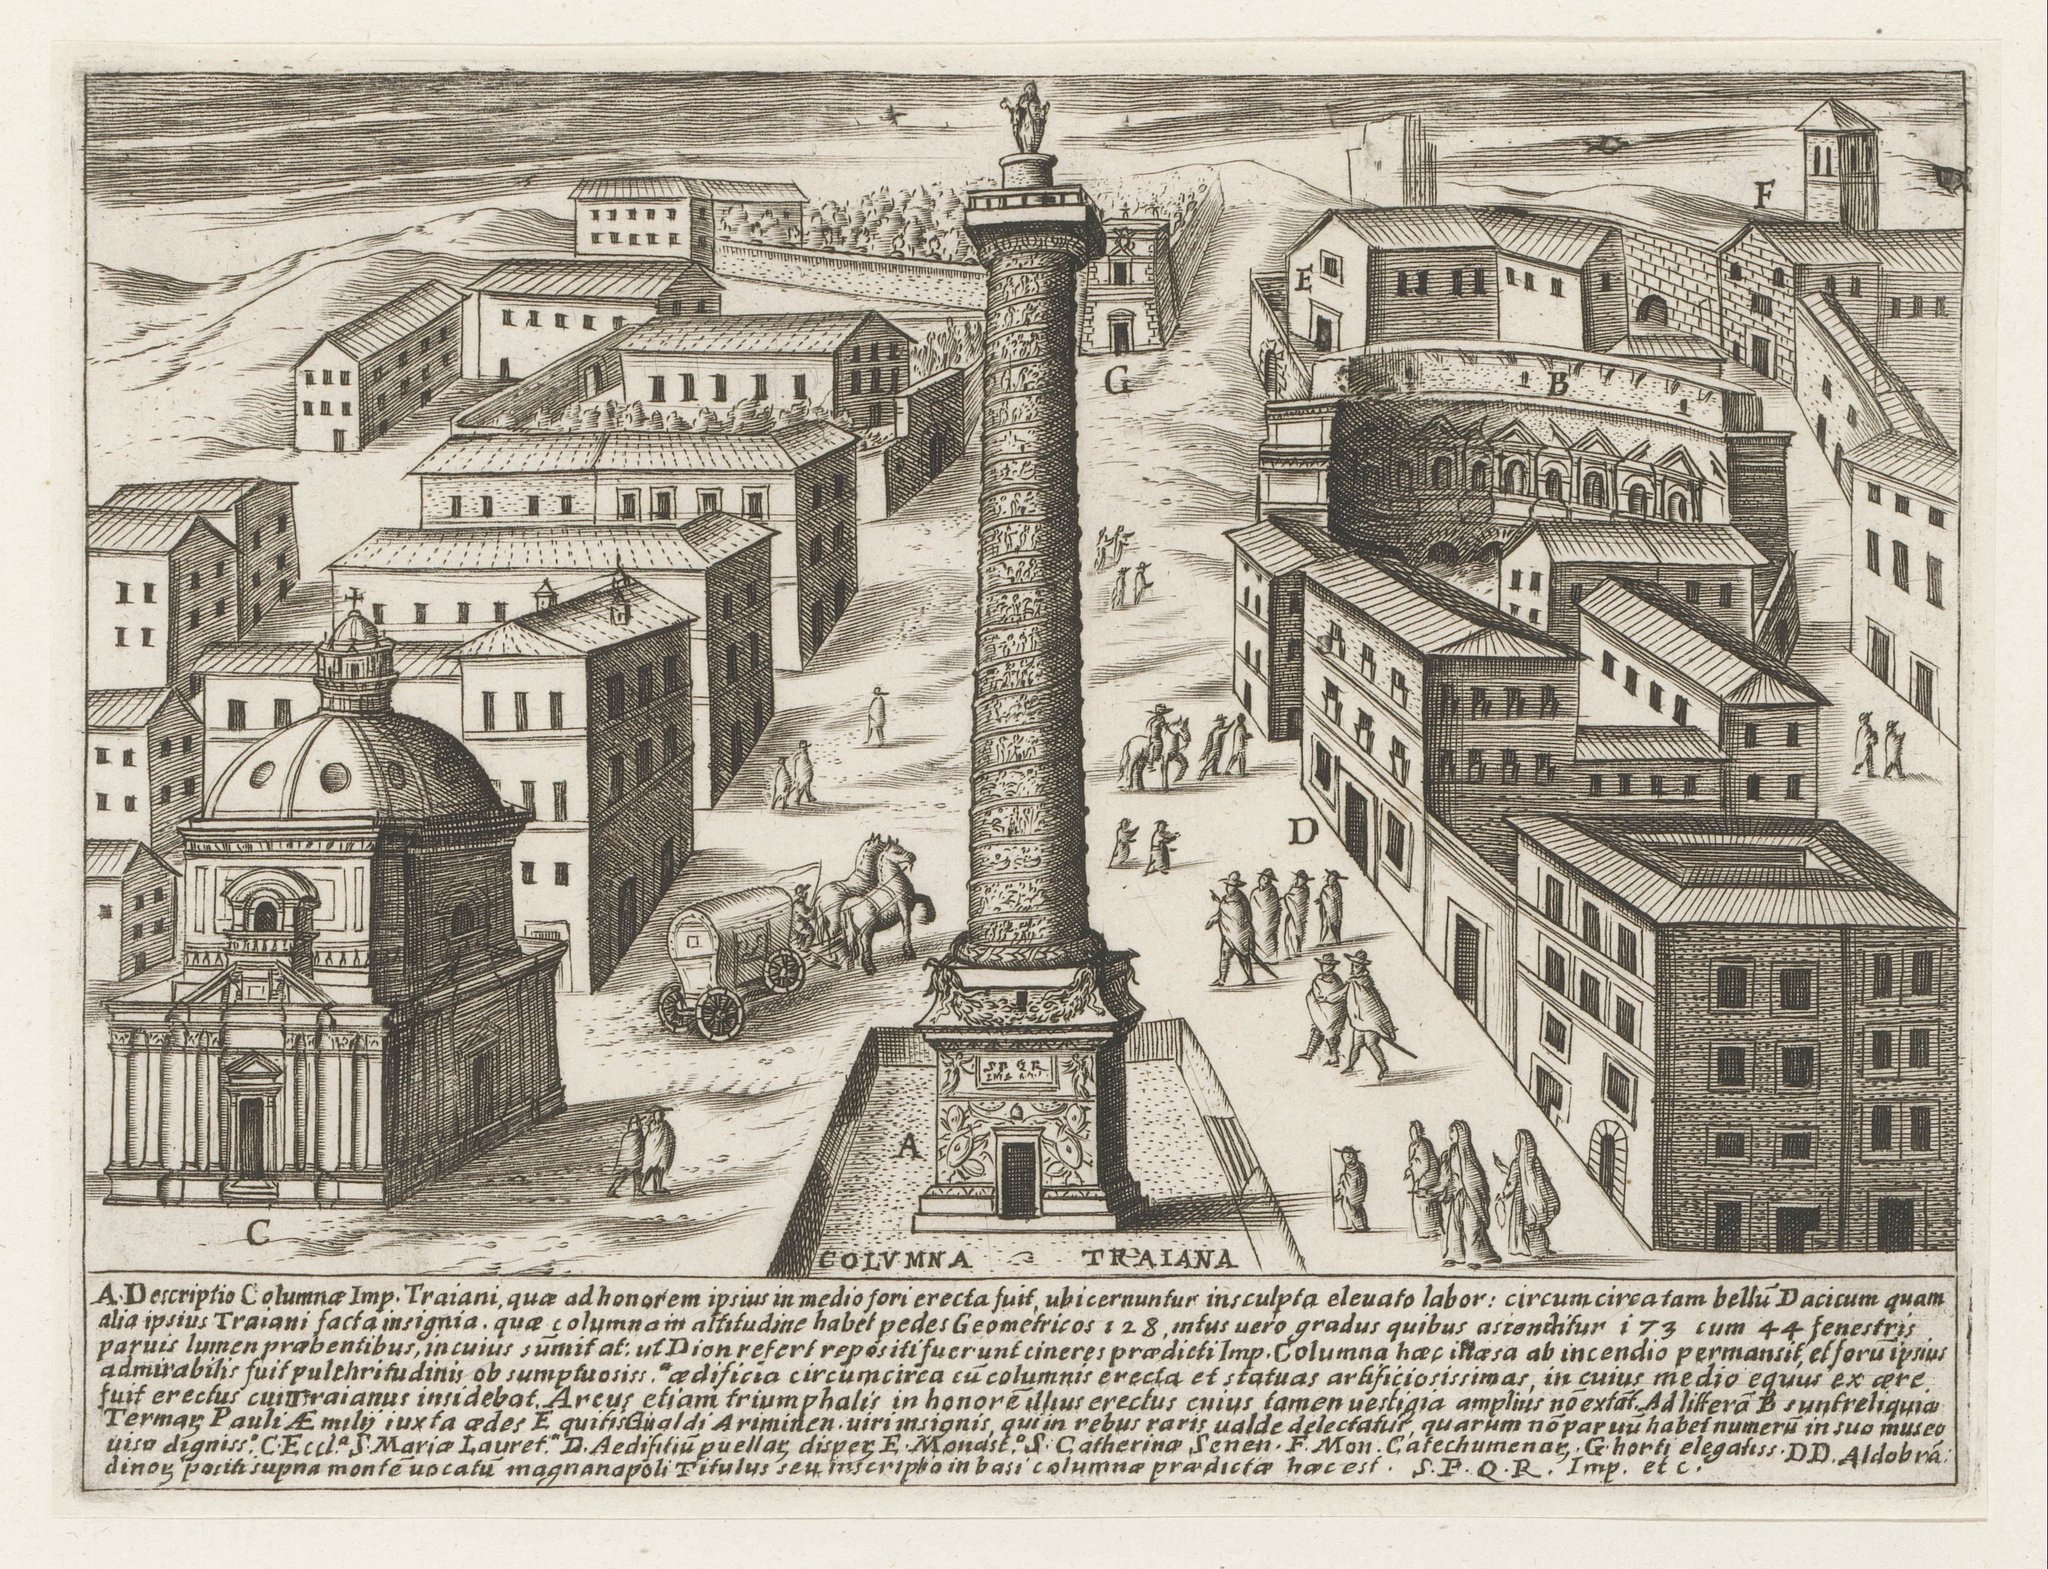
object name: print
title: Magesyn der Italiaense gebouwen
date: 1612-1628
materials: paper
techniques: etching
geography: rome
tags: triumphal column with helical friezes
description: Deze prent maakt deel uit van een set van 158 prenten (+ titelprenten), die verscheen in vier delen. In 1612 verschenen delen één en twee. In 1615 verscheen het derde deel en in 1628 verscheen deel vier. In 1637 publiceerde Vitale Mascardi de eerste heruitgave van de gehele set met nummering.